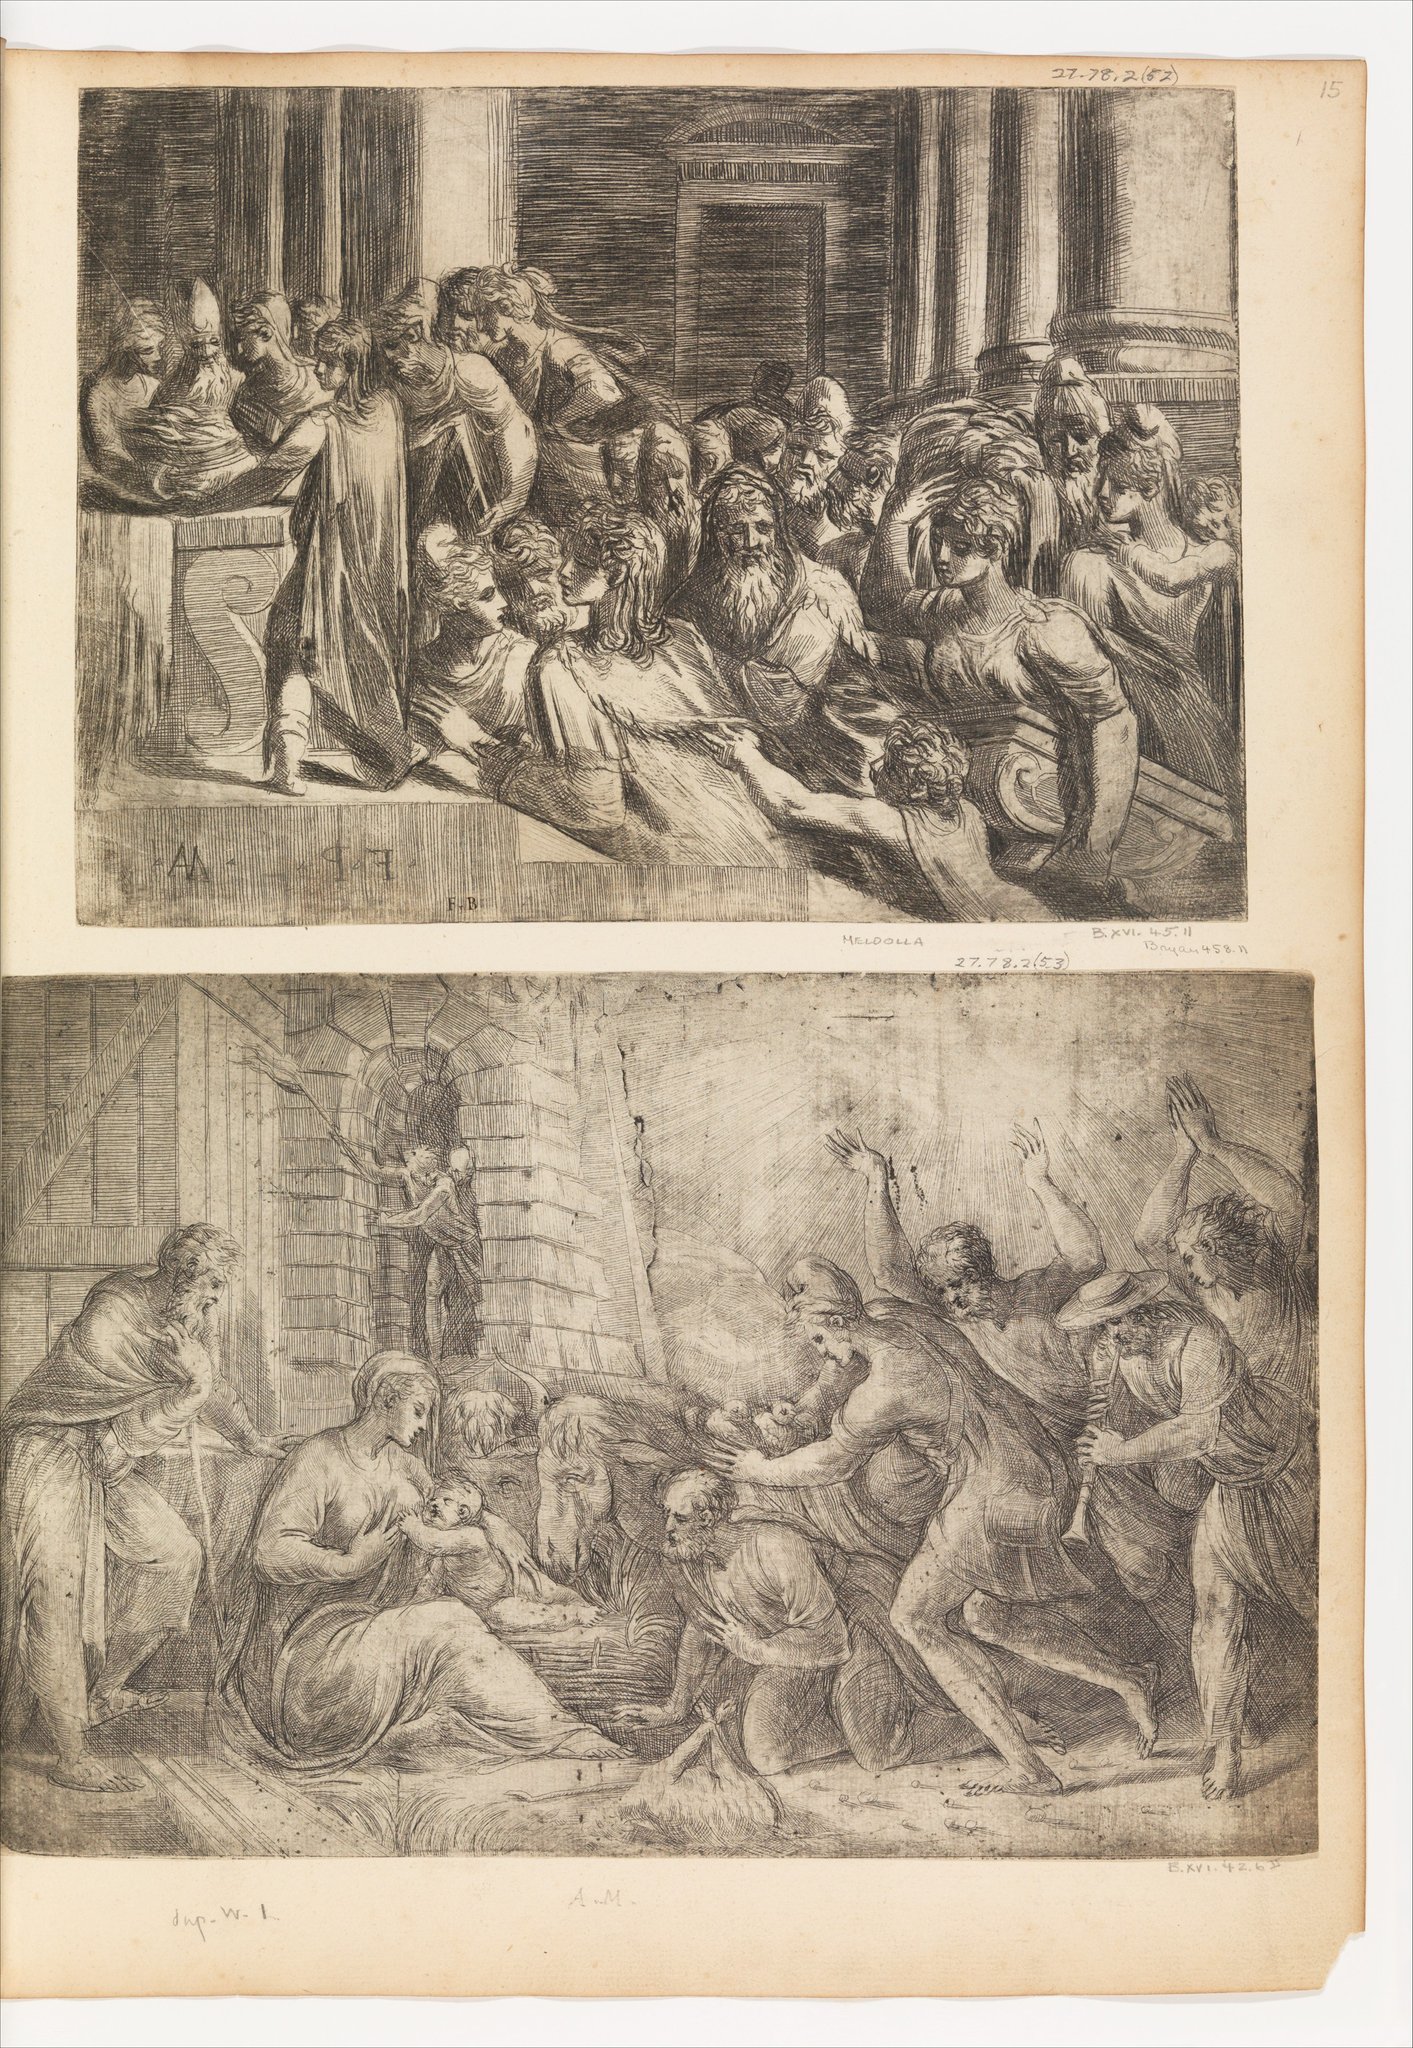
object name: print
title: The Presentation in the Temple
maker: andrea schiavone (andrea meldola)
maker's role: artist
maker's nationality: italian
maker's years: 1510-1563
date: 1540-1545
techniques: drypoint, etching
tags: temples,men,christ,virgin mary